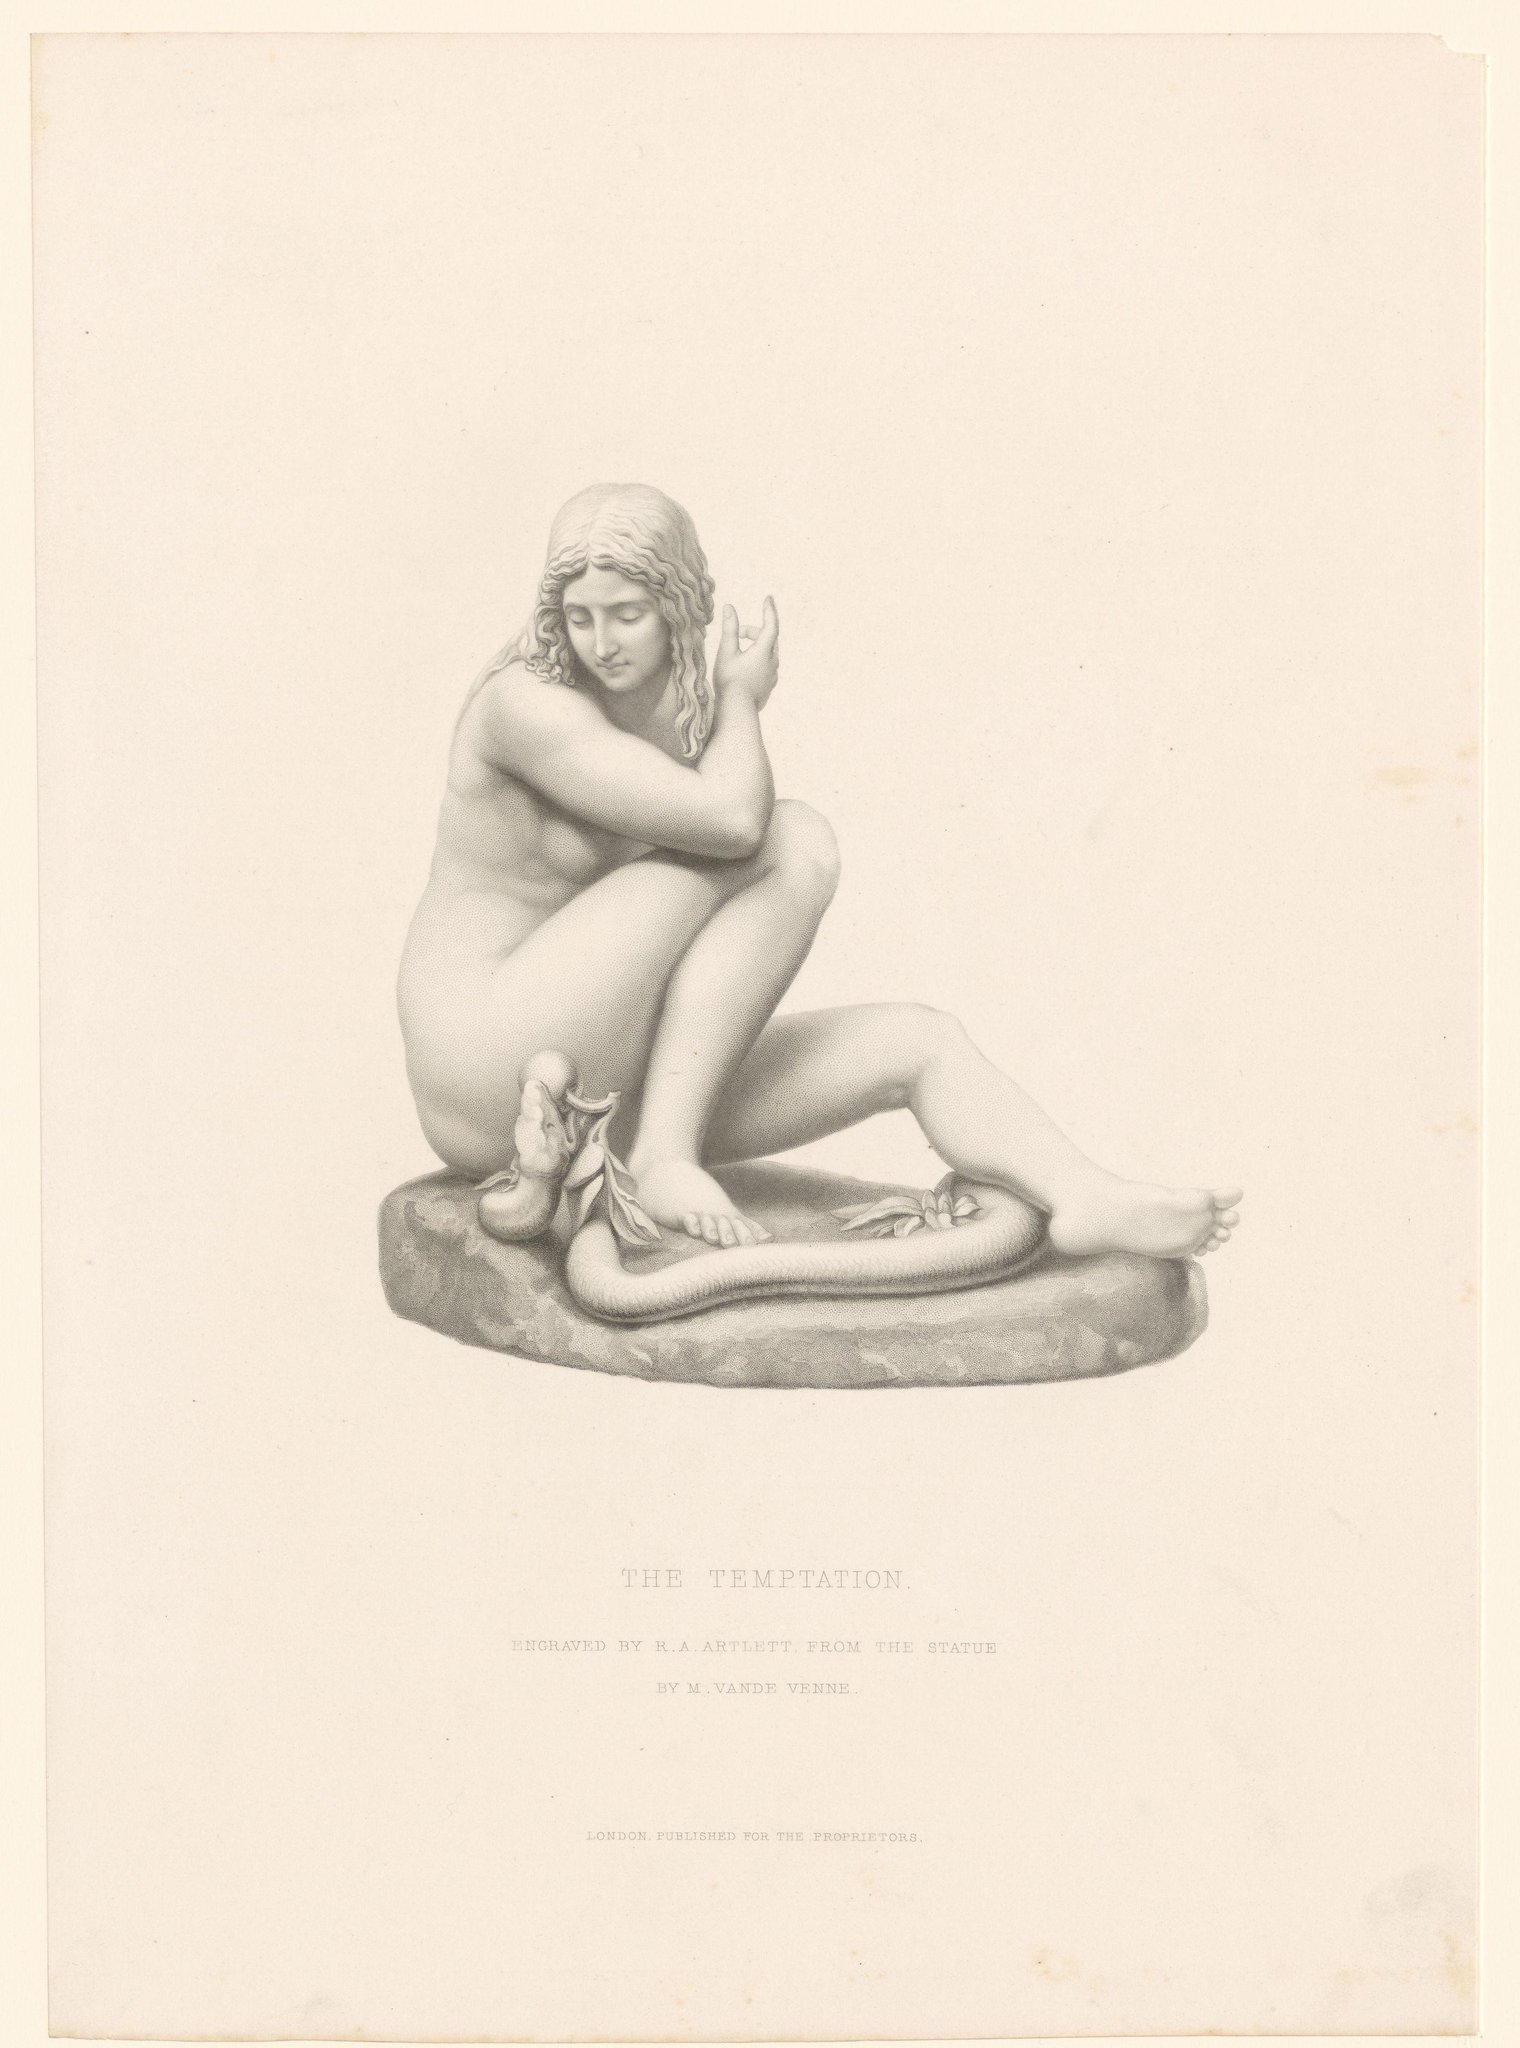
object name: book illustration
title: The temptation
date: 1855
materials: paper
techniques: engraving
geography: england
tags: the serpent tries to persuade eve to take some of the fruit (usually an apple)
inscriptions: collector's mark: Lugt 2228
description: Prent uit: The Art Journal, 1855, dl. 1, tussen p. 156 en 157.